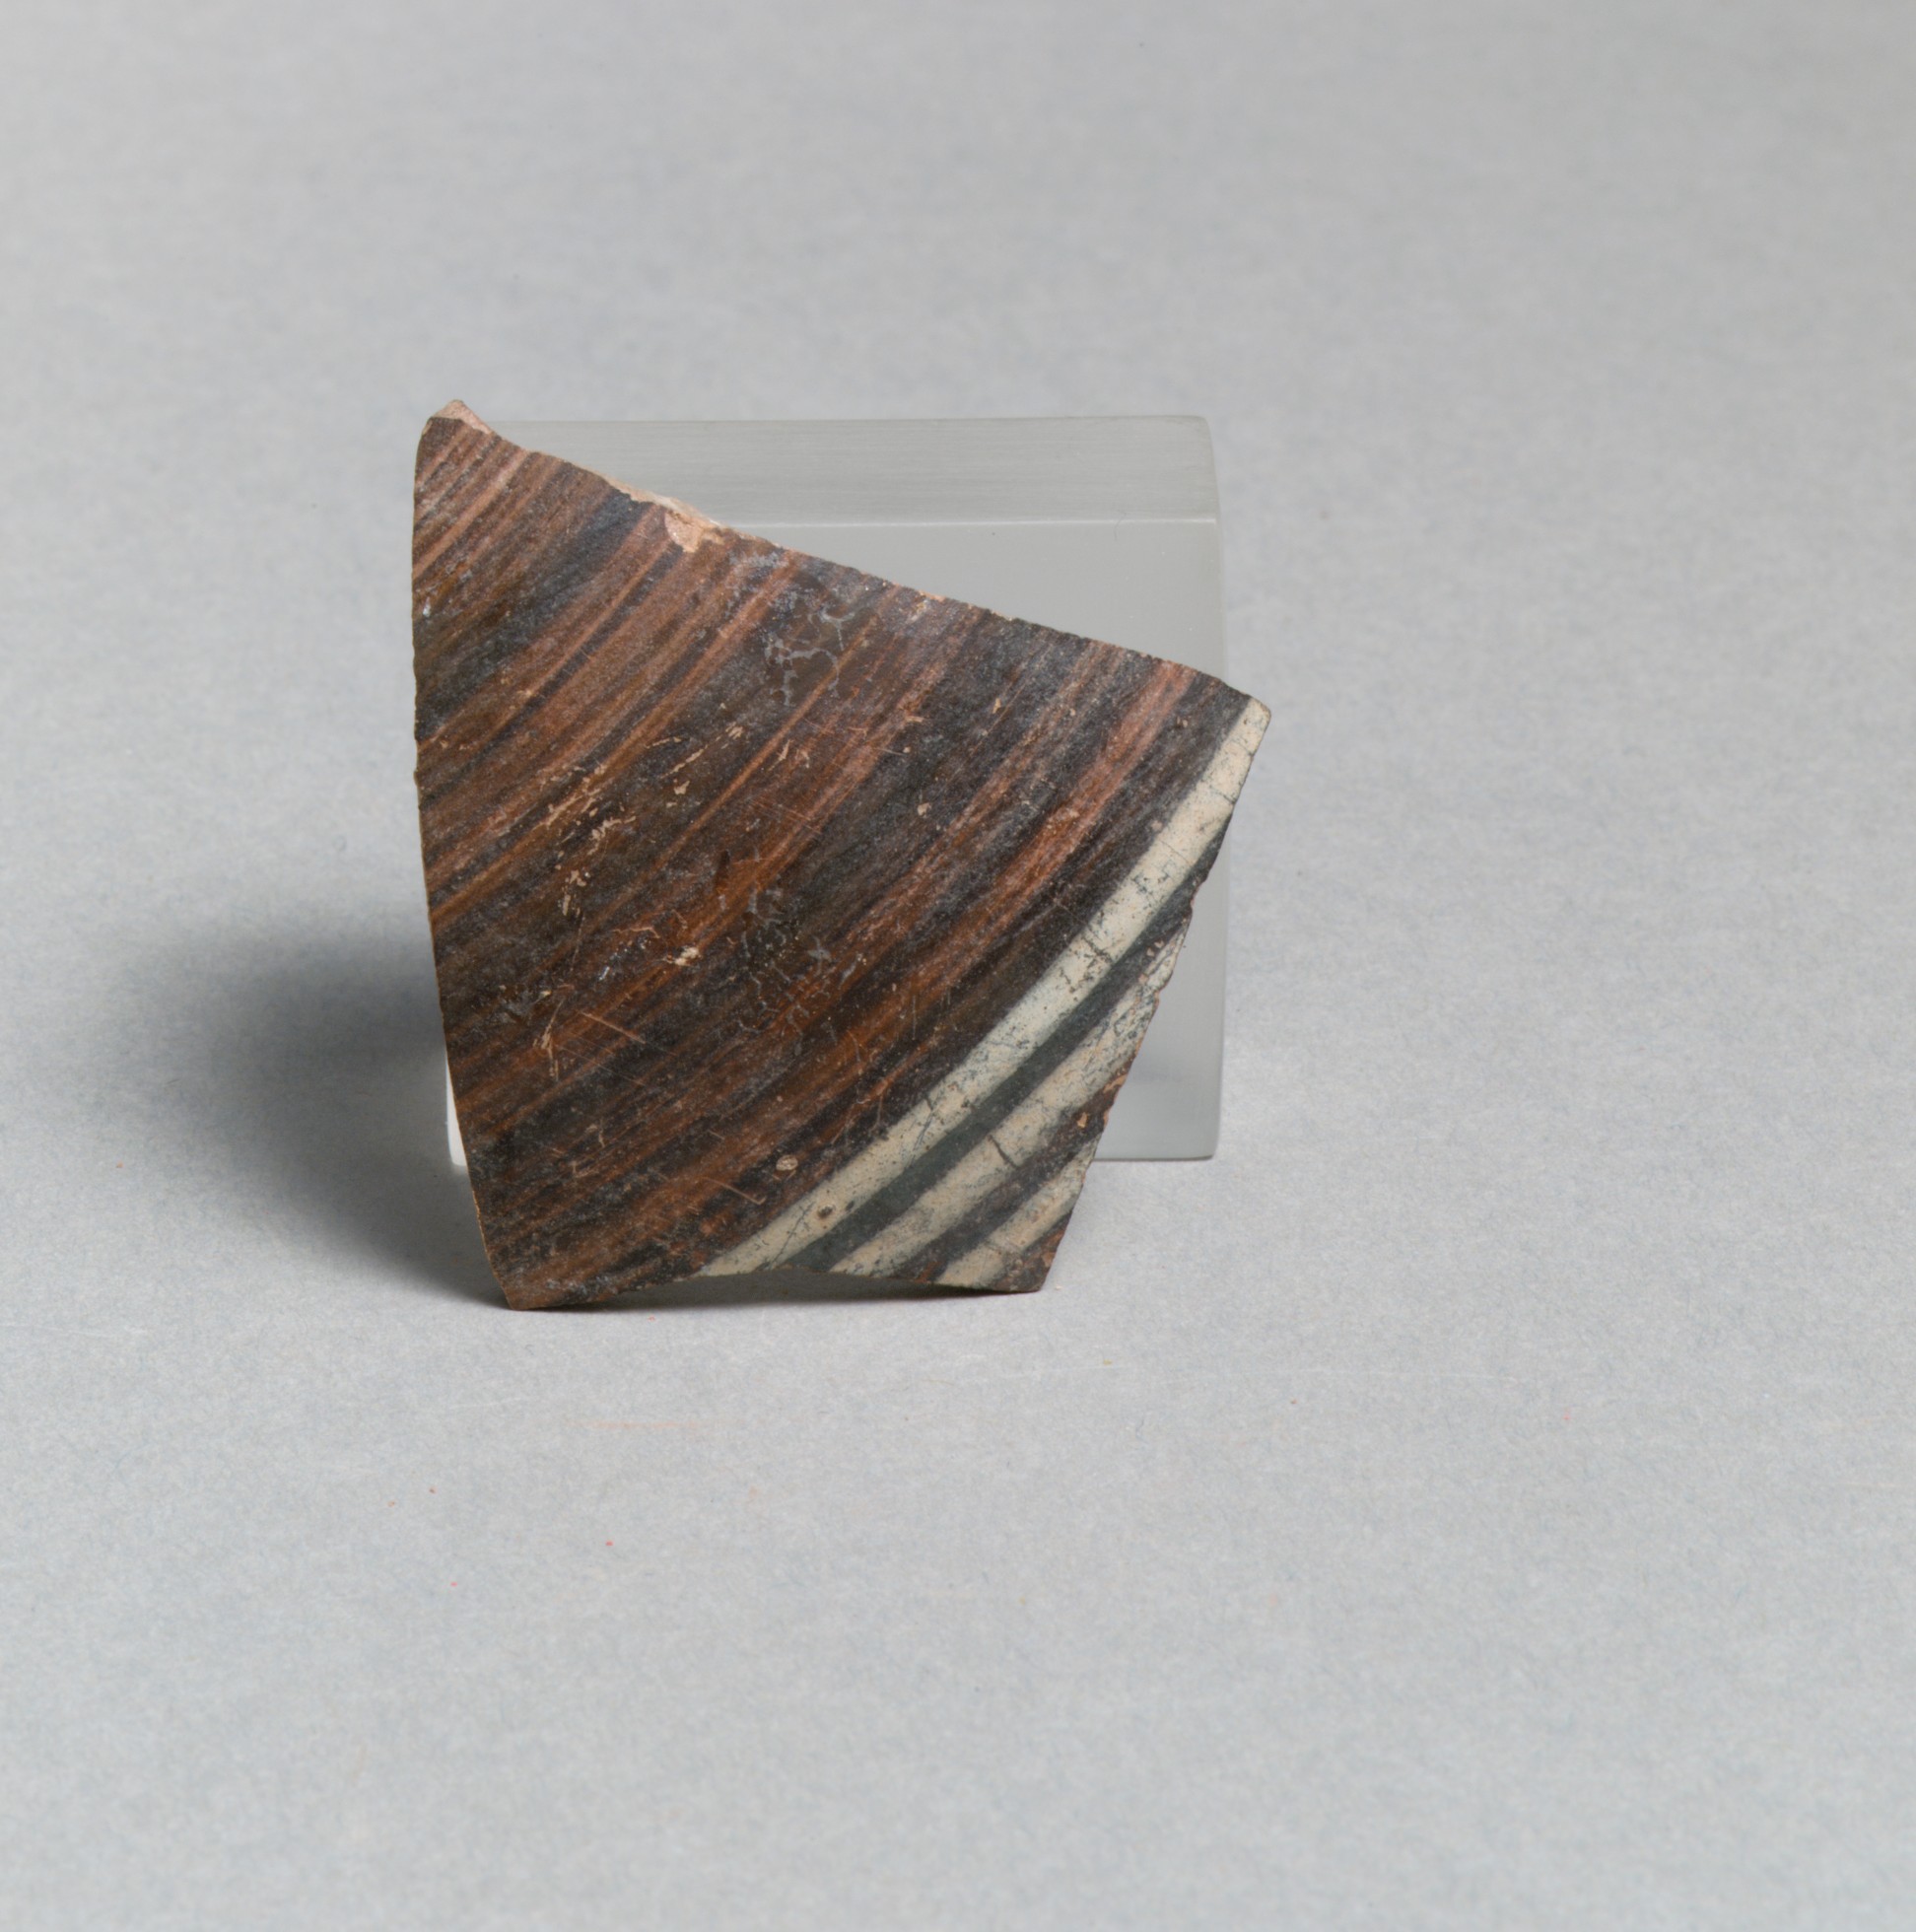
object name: vase fragment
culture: greek or lydian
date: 900-30 BCE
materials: terracotta